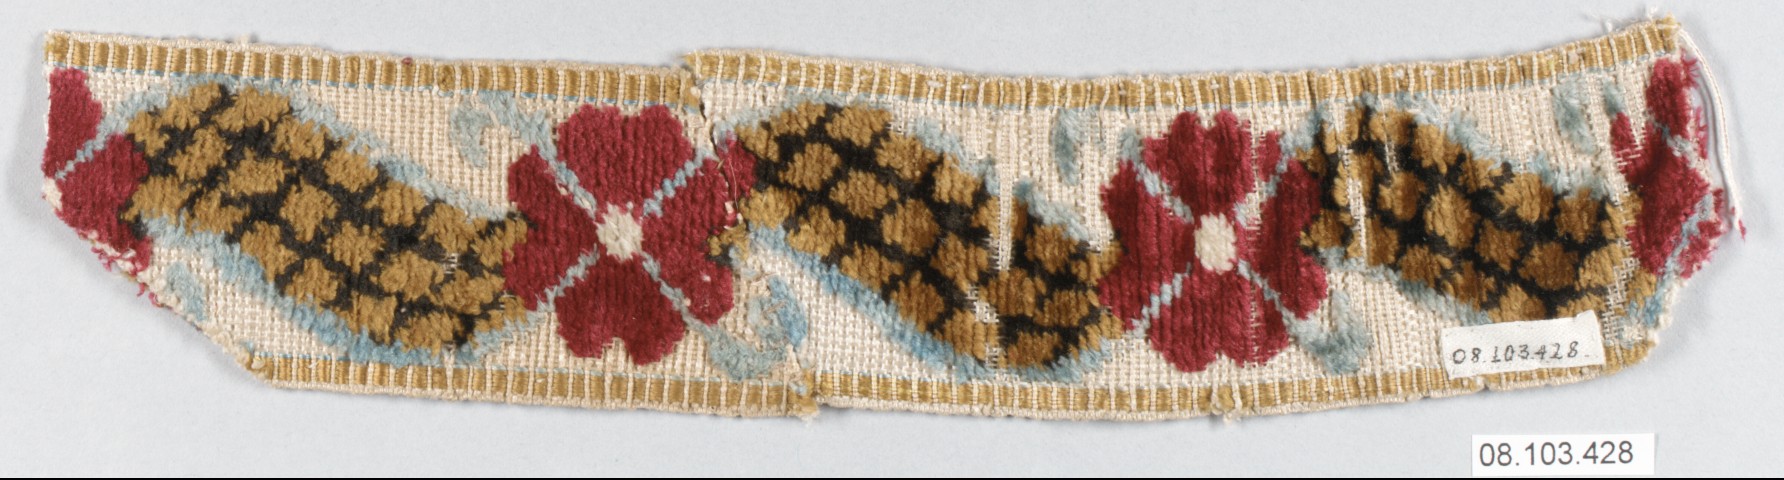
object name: galloon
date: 1701-1900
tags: flowers